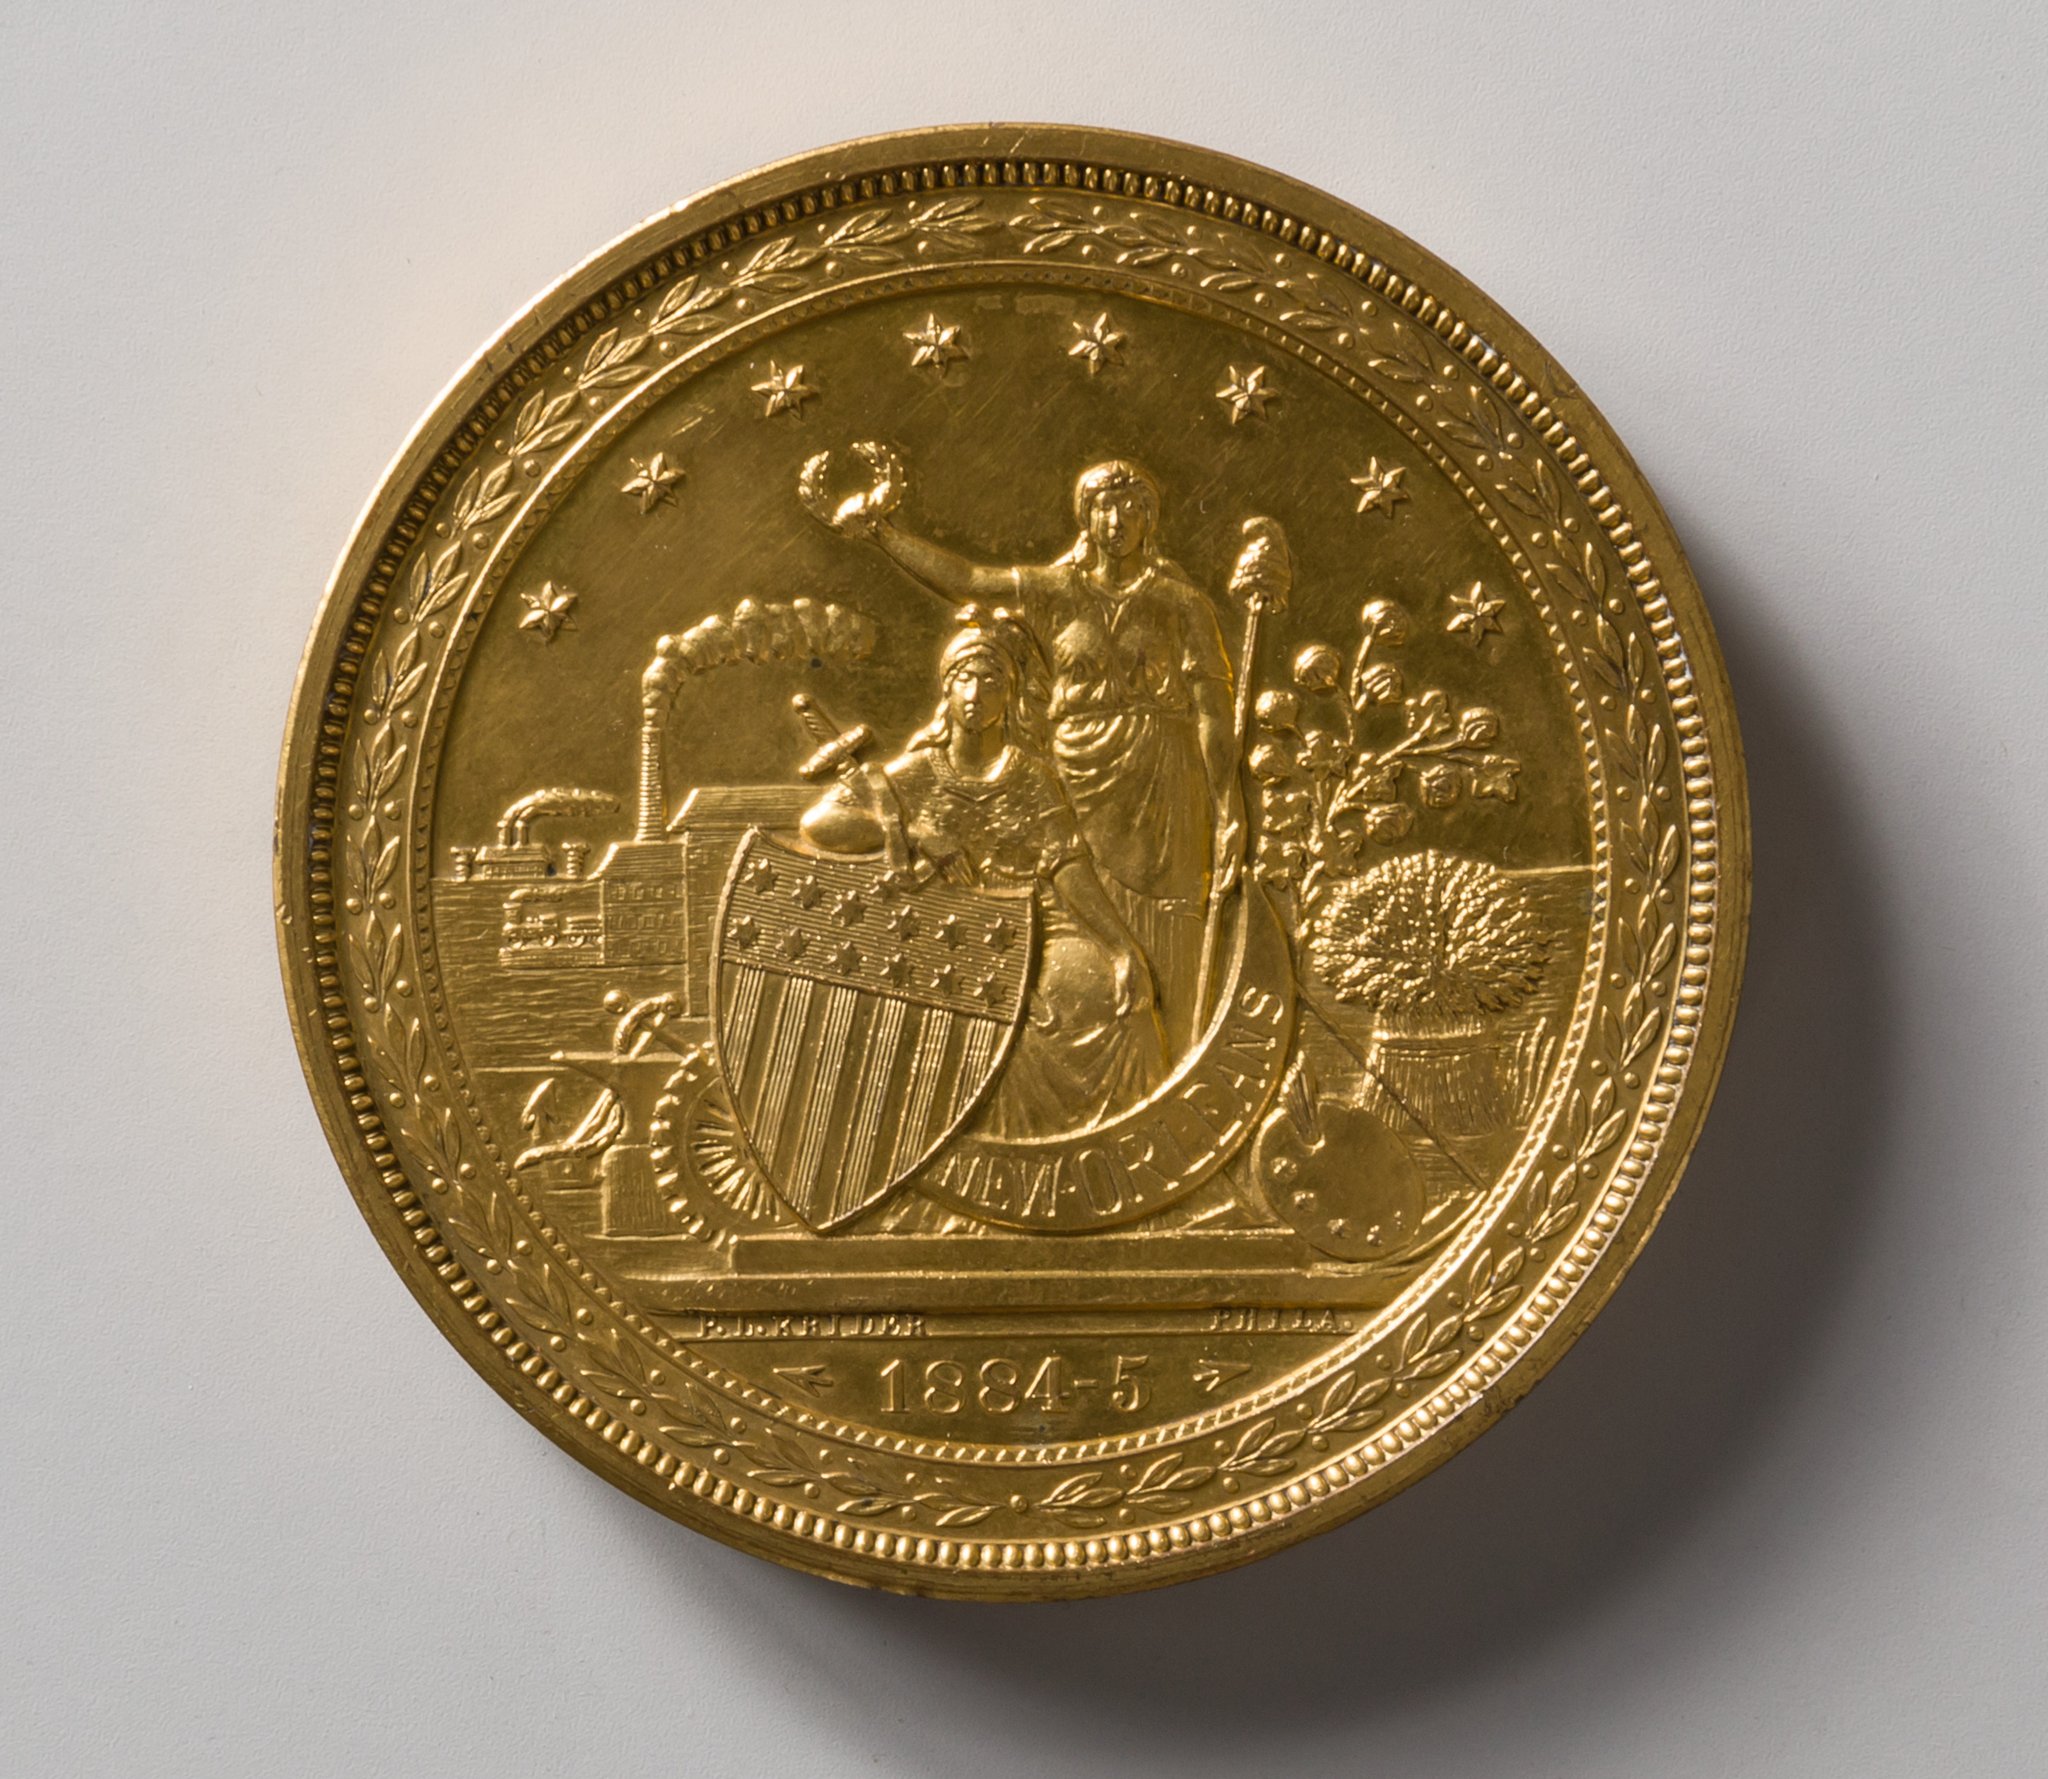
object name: medal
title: Award Medal of the New Orleans Cotton Centennial Exposition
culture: american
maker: p. l. krider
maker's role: artist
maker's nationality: american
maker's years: 1821-1895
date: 1884-1885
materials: bronze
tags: shields,women,stars